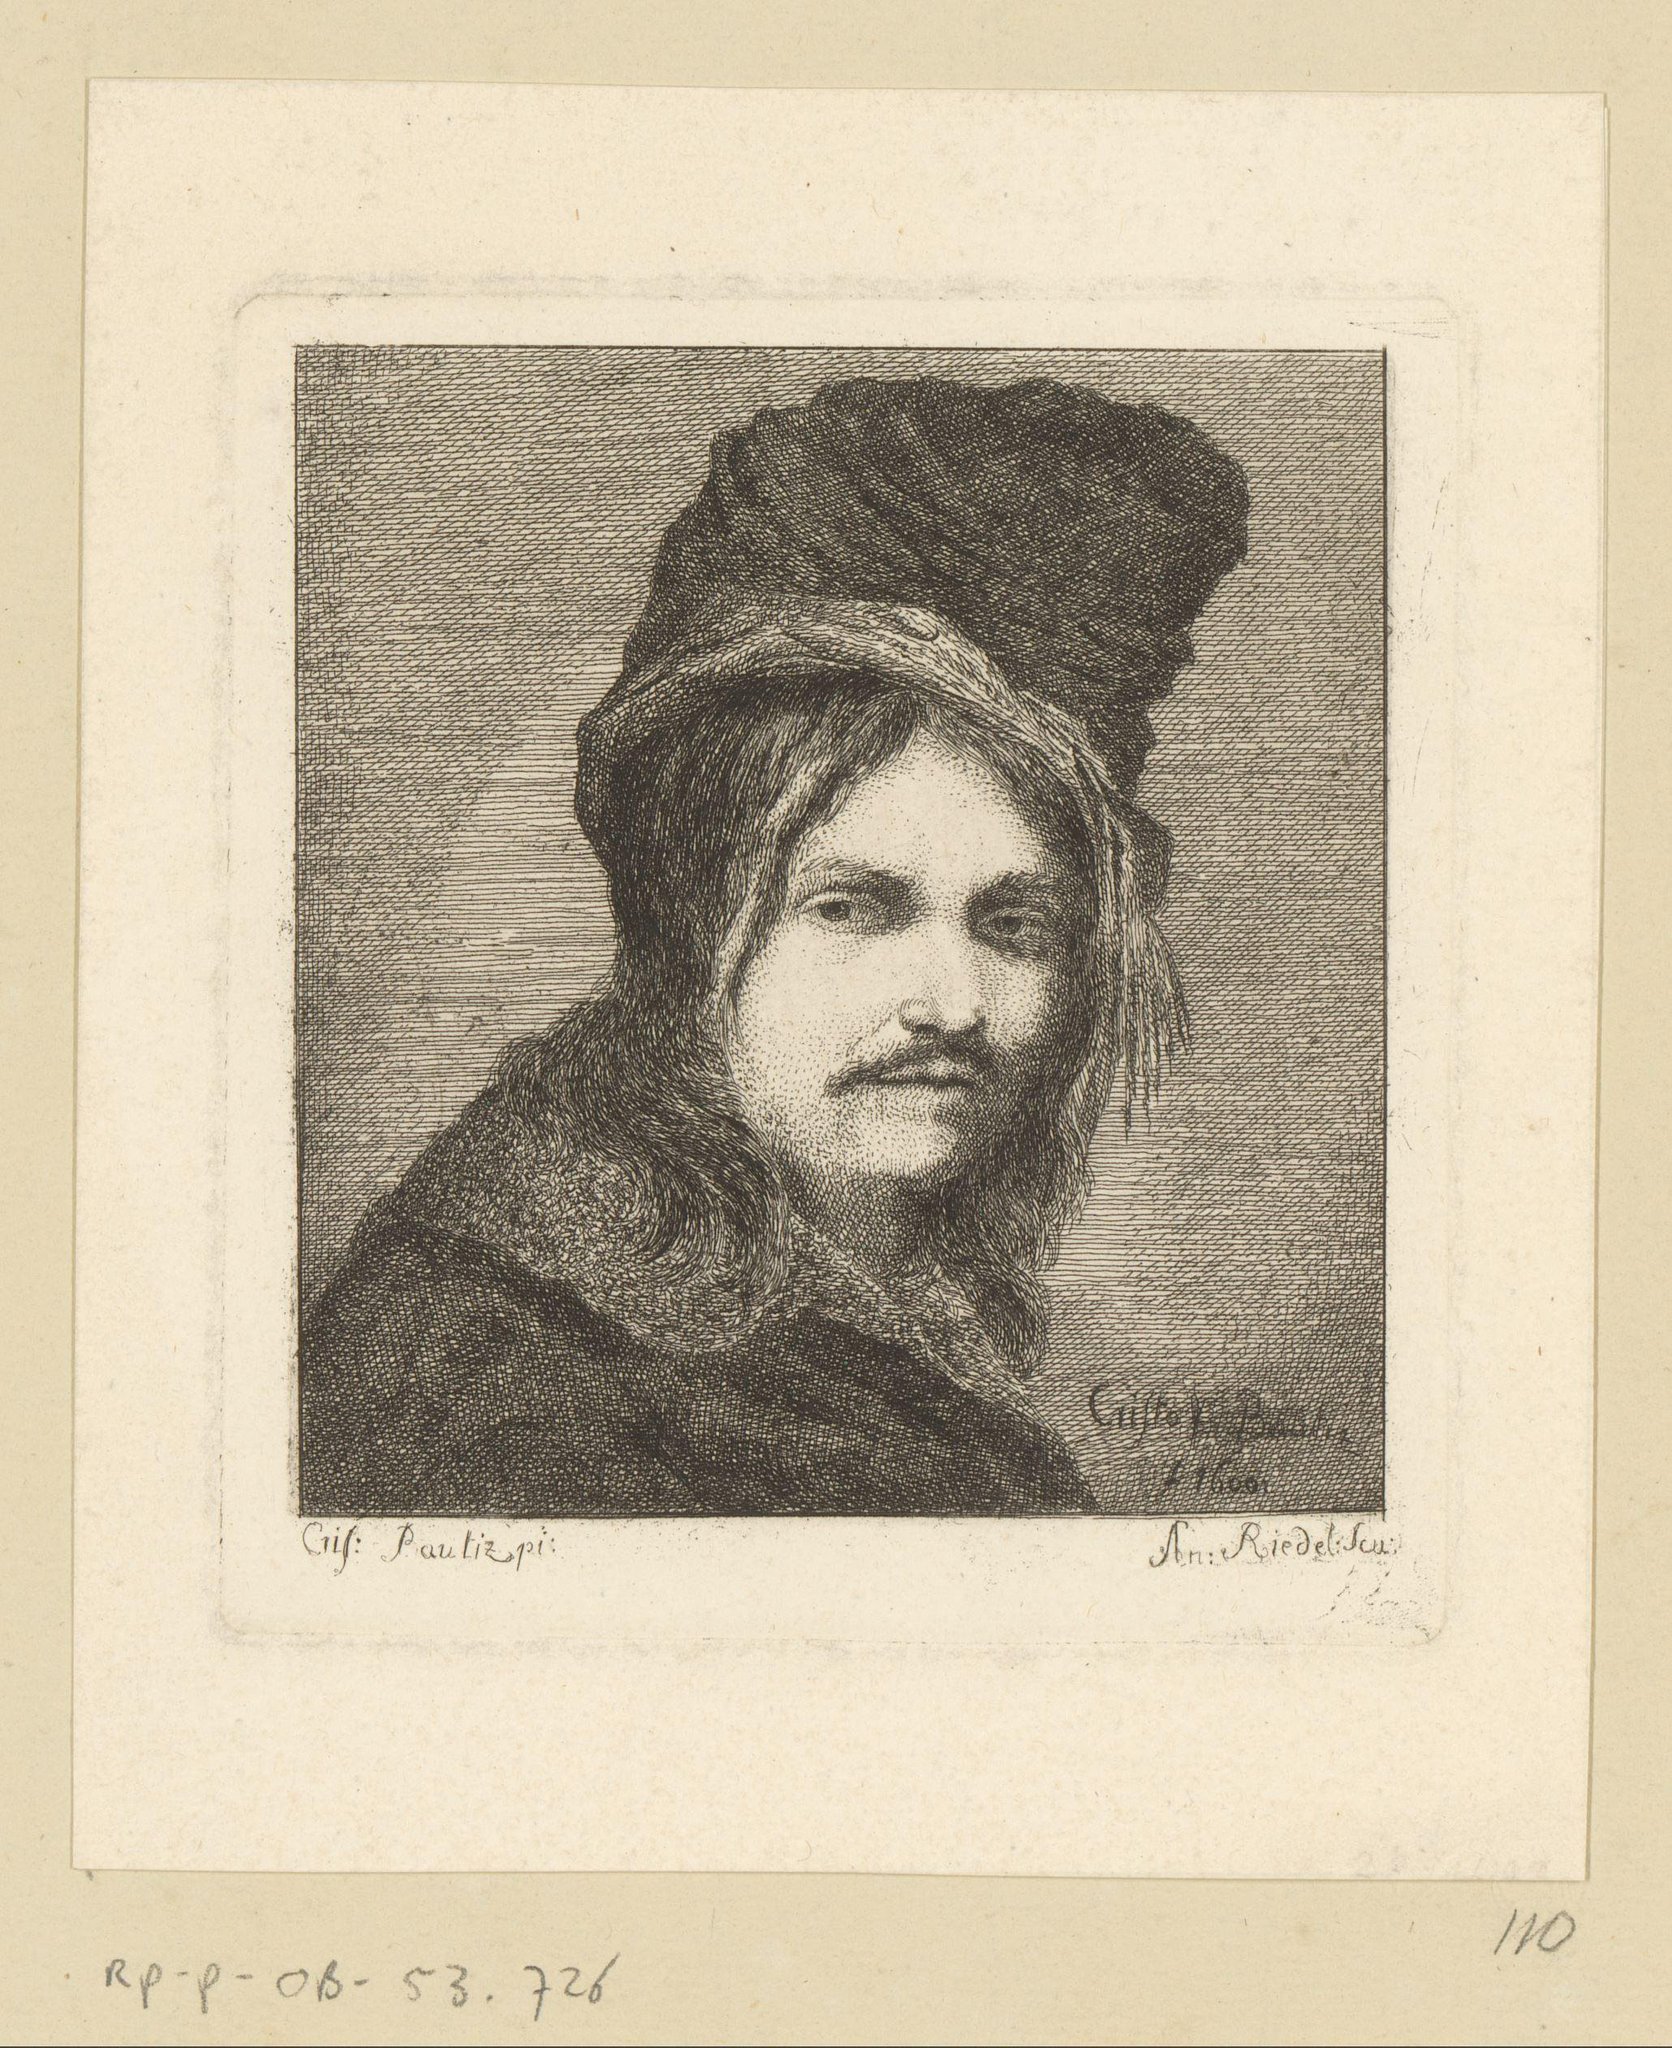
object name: print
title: Portret van een onbekende man met hoge muts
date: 1746-1816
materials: paper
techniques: etching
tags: head-gear: cap (+ men's clothes), adult man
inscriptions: collector's mark: Lugt 2228